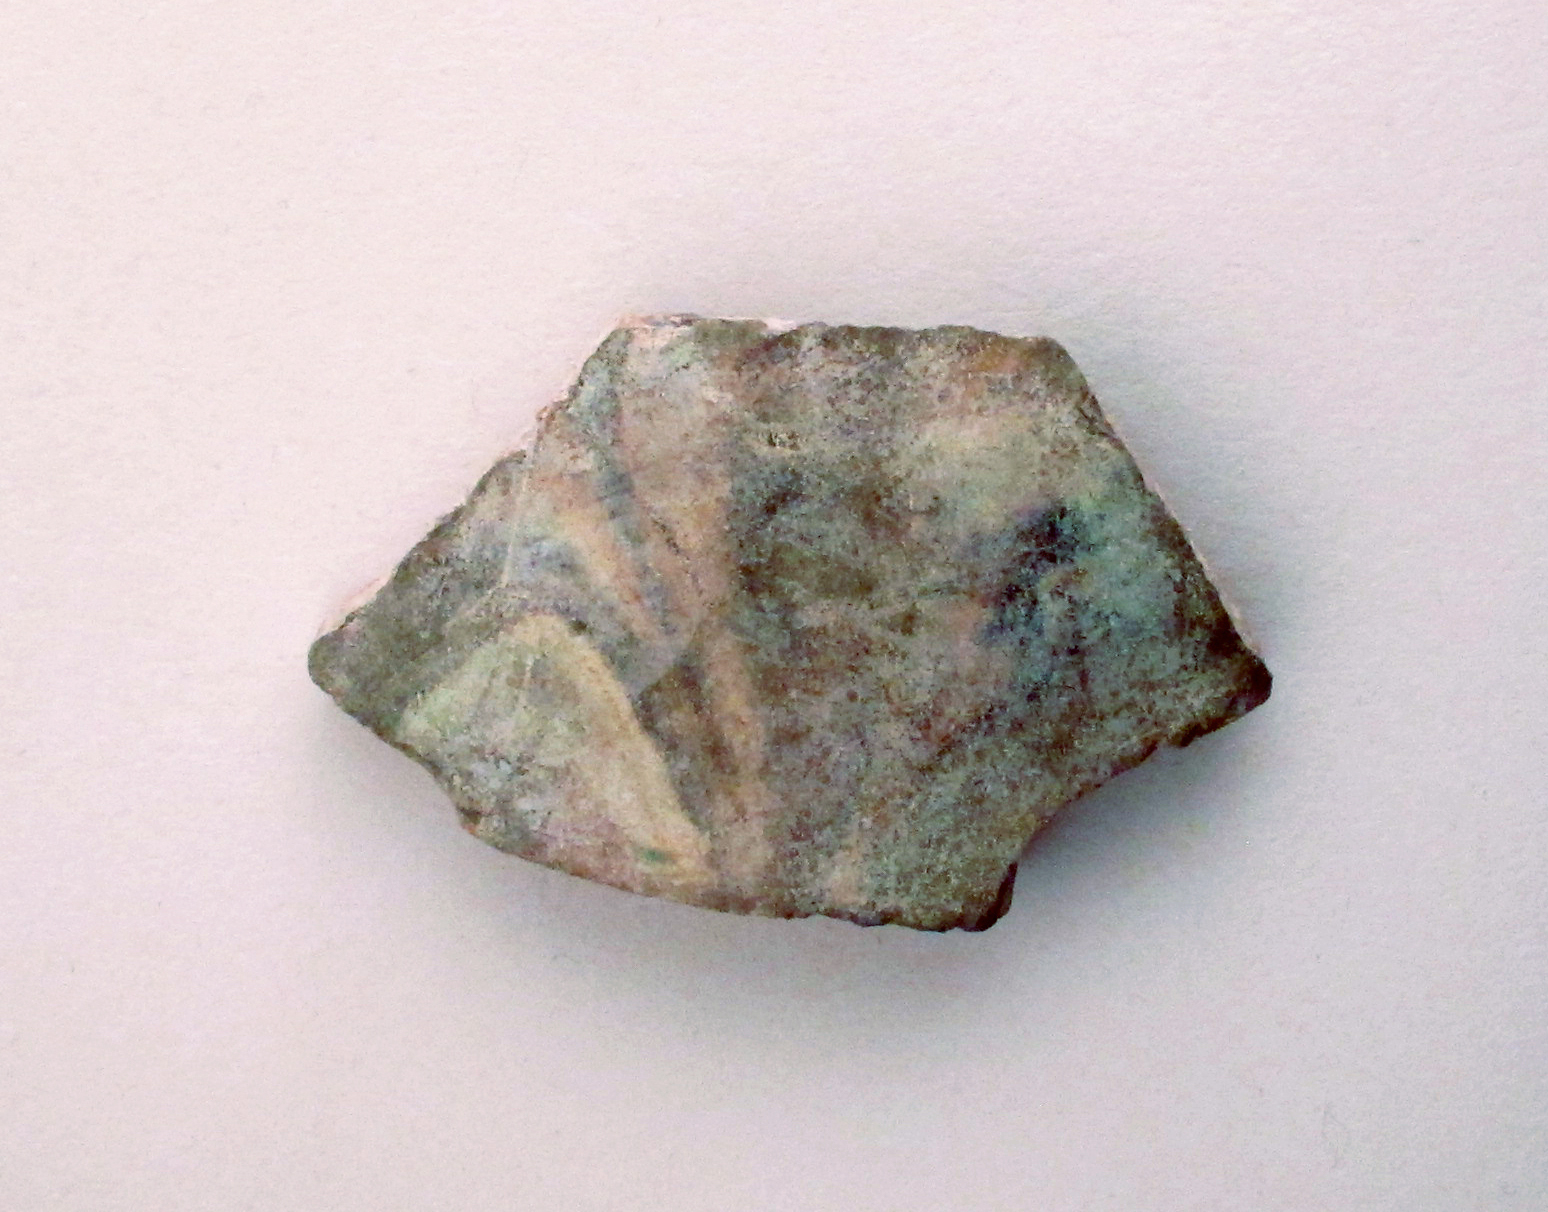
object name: vase fragment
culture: roman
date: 670 BCE-330 CE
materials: terracotta